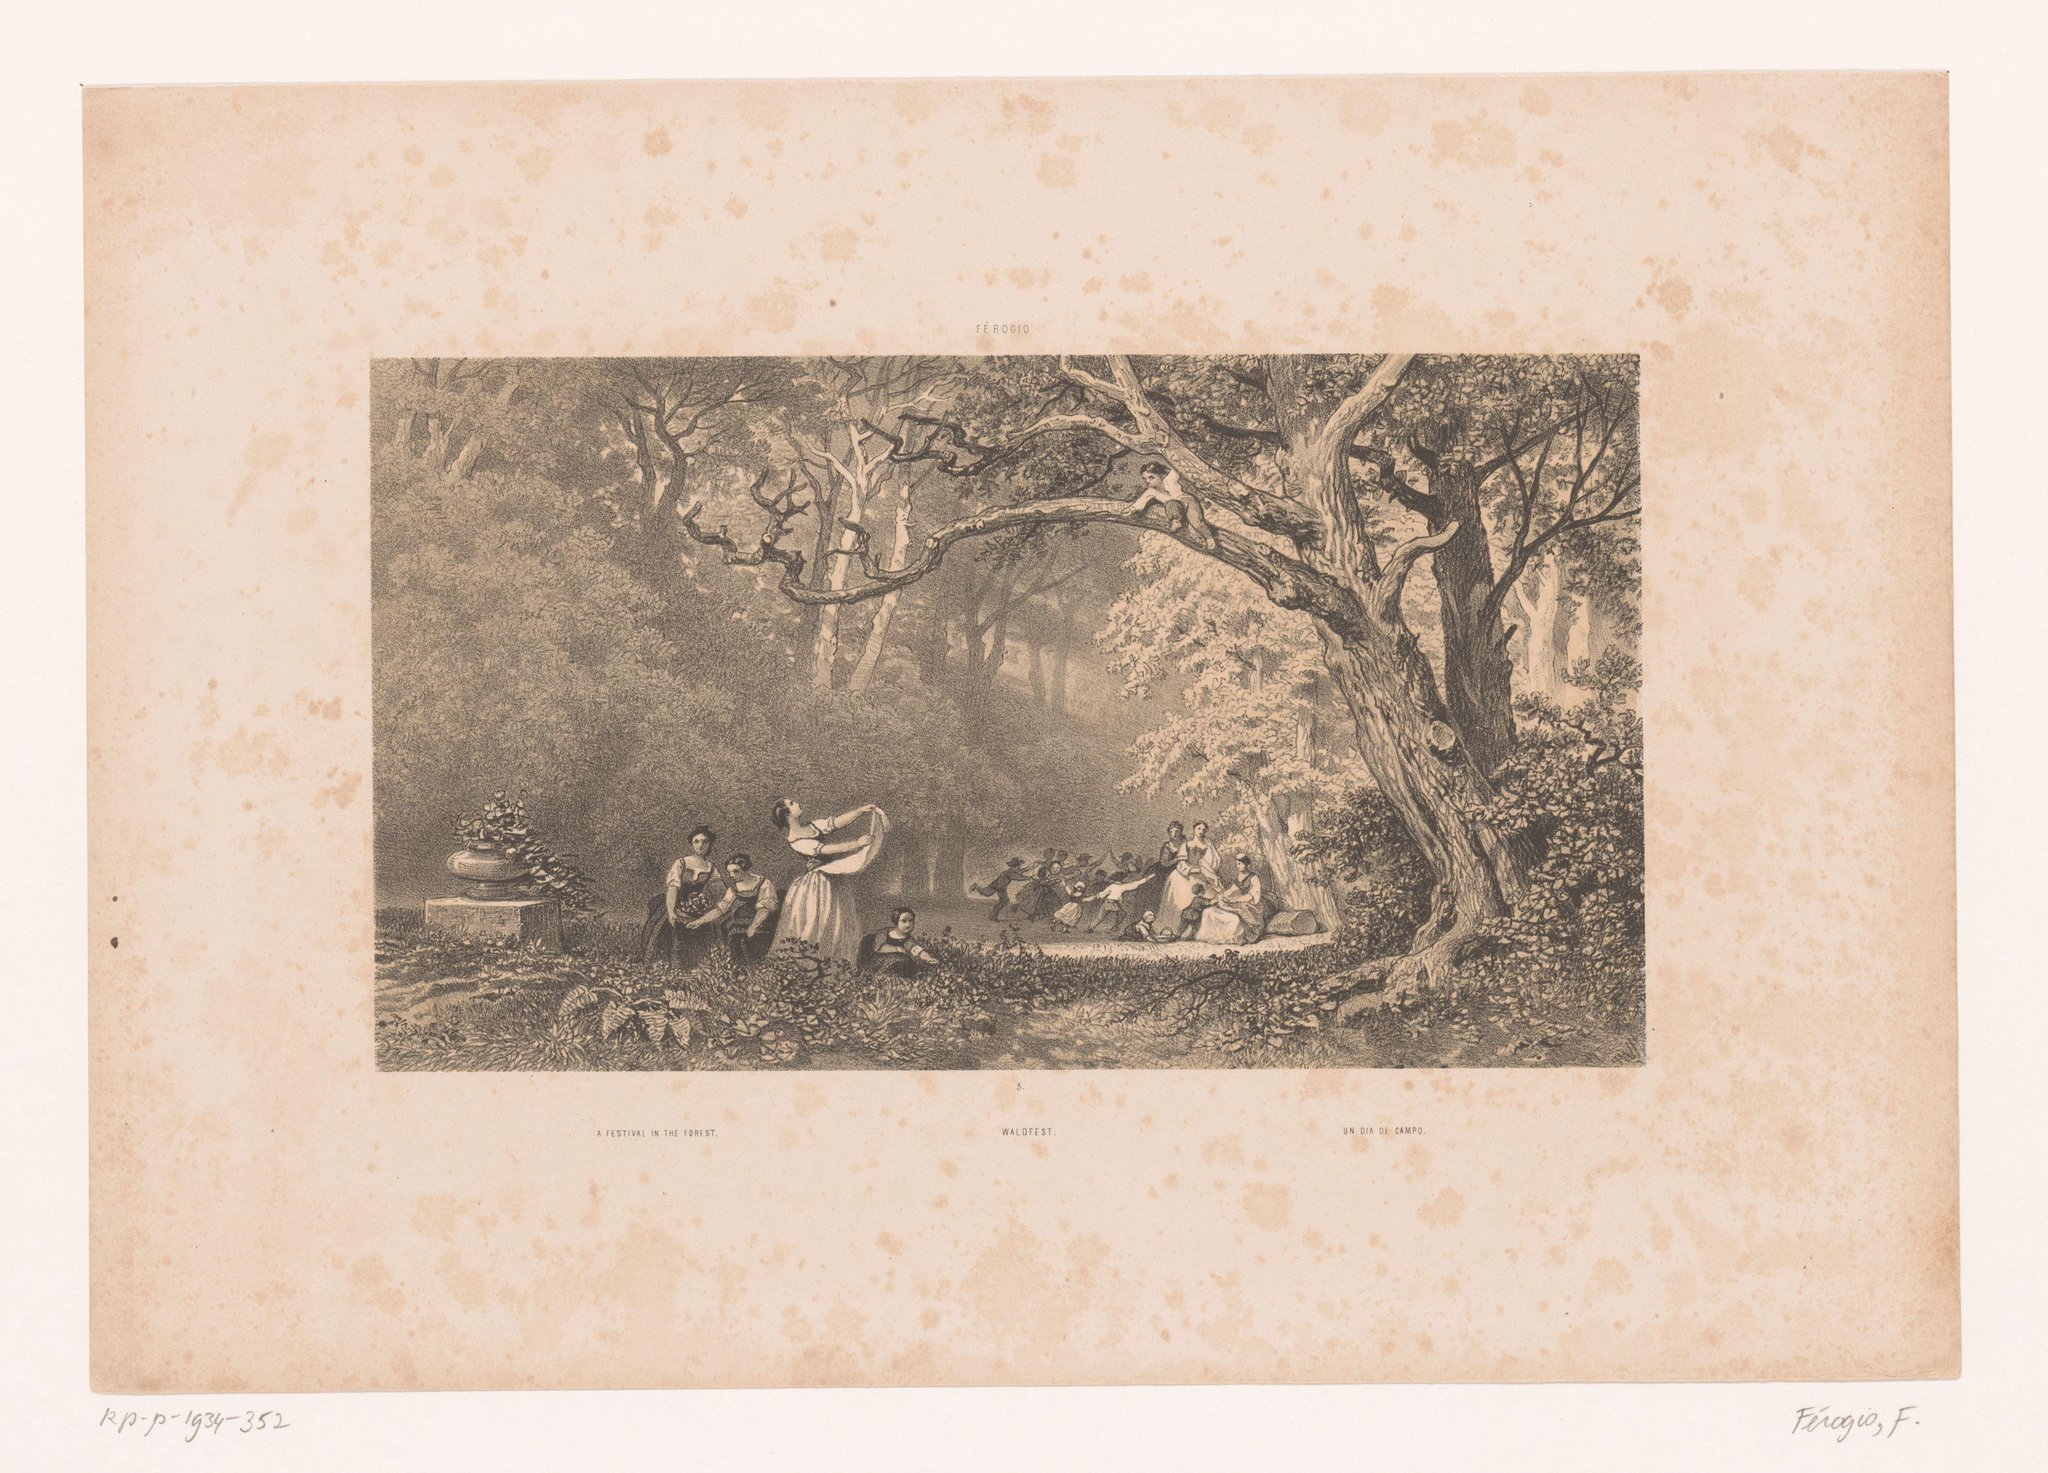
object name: print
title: Figuren in een landschap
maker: fortuné férogio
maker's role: print maker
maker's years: 1805-1888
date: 1829-1875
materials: paper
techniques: tone lithography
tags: forest, wood, child and nature (games and plays)